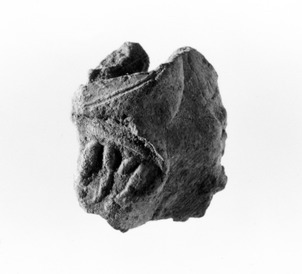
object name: sealing, djed, cobra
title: Document Sealing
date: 1390-1352 BCE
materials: mud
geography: egypt